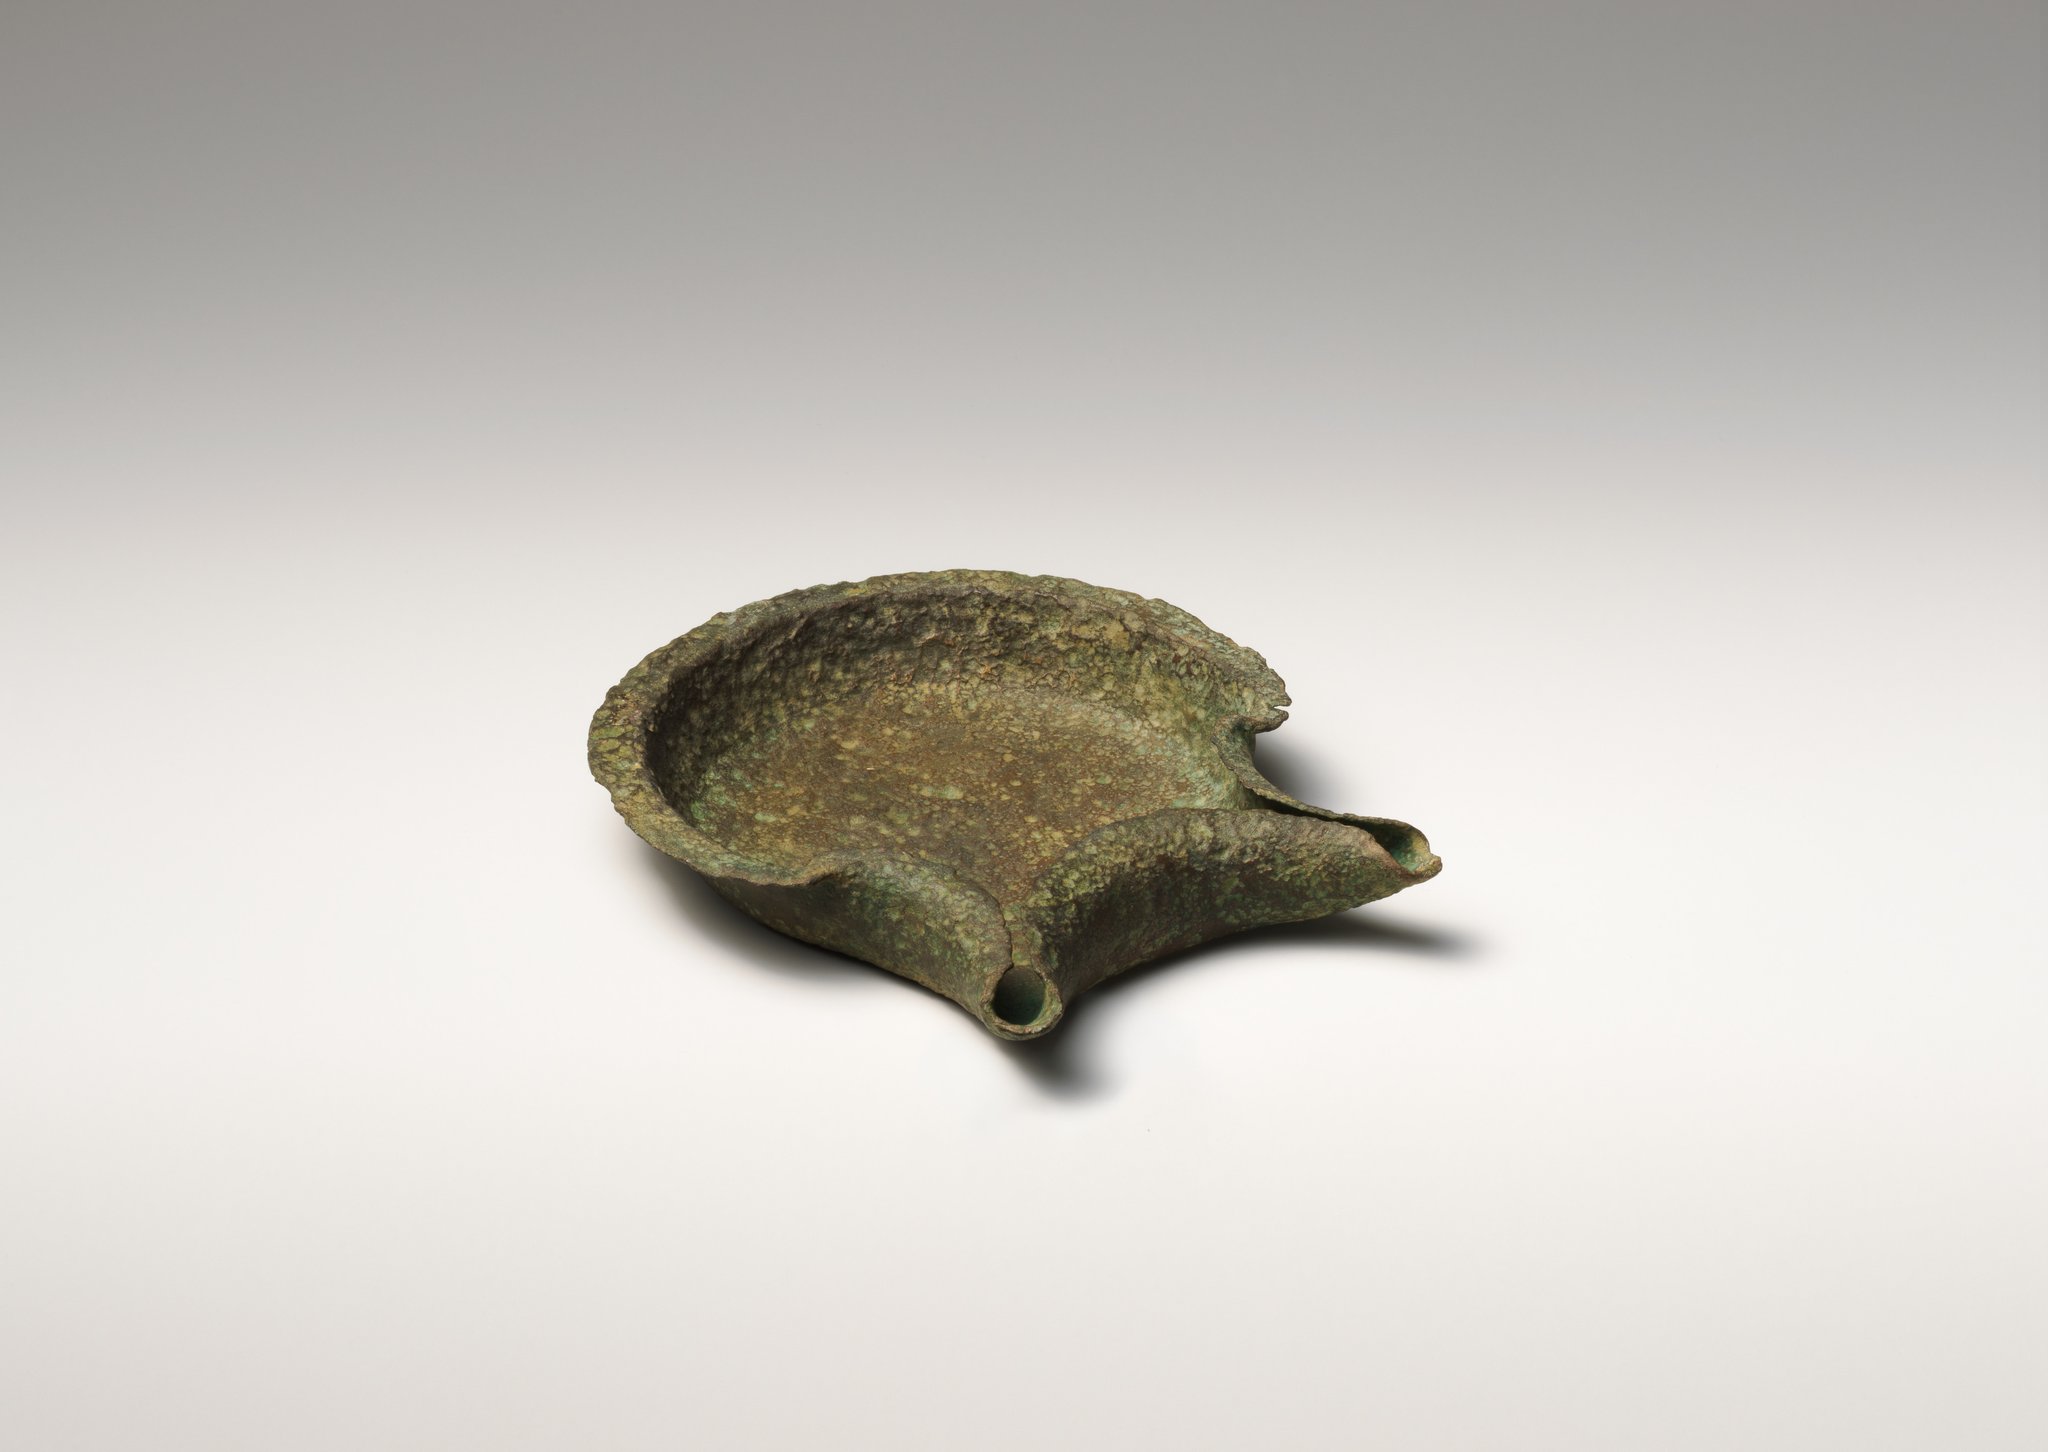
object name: lamp, saucer shaped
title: Bronze saucer-shaped lamp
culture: cypriot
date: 600-401 BCE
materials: bronze